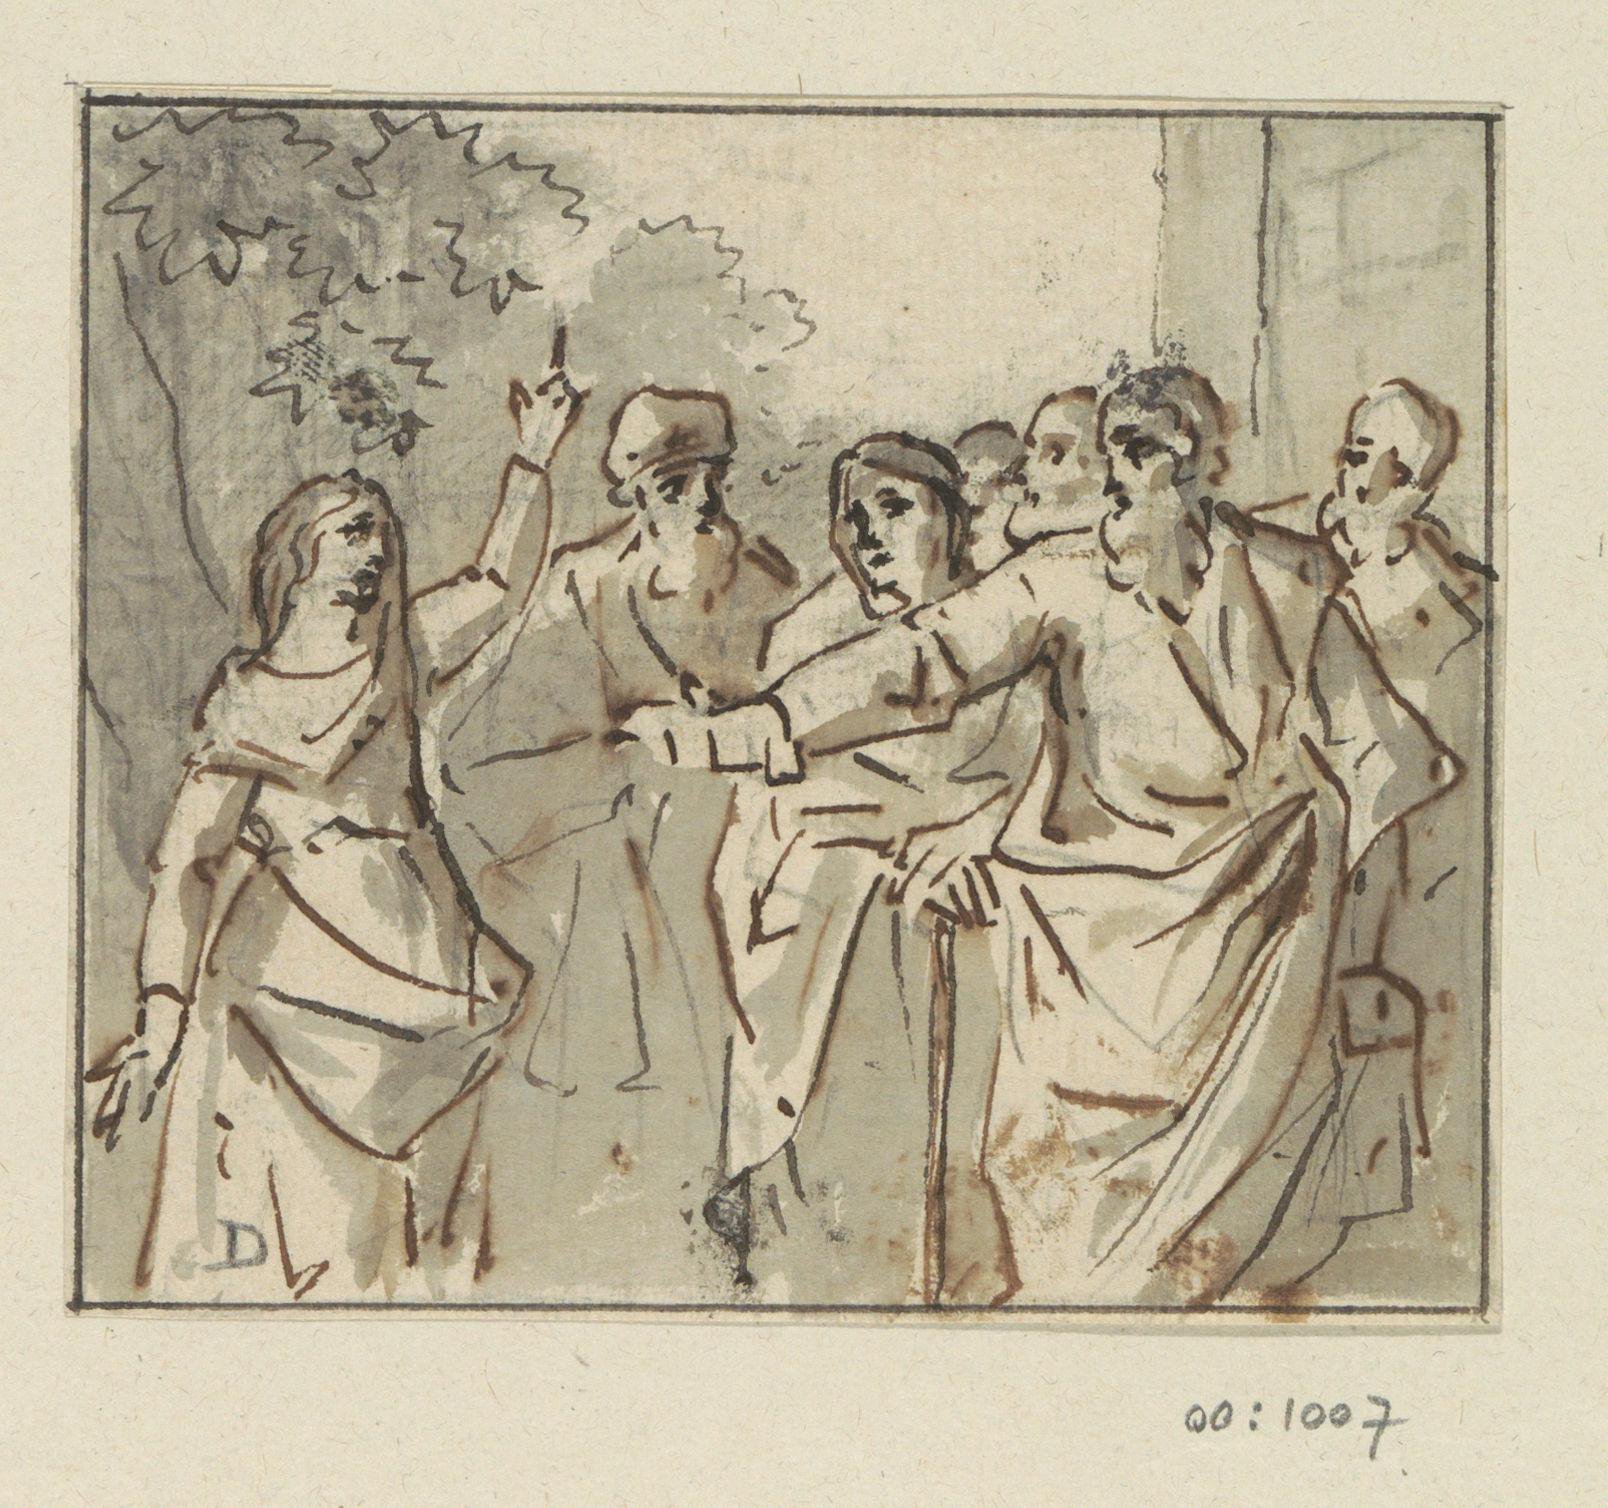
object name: drawing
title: Paulus verdrijft een boze geest uit de dienstmaagd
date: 1760-1819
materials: paper, pencil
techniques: brush, pen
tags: life and acts of paul (saul)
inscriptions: inscription: ‘Jacob Bakker pinxit/ in de collectie van J Andriessen/ te Amsterdam’